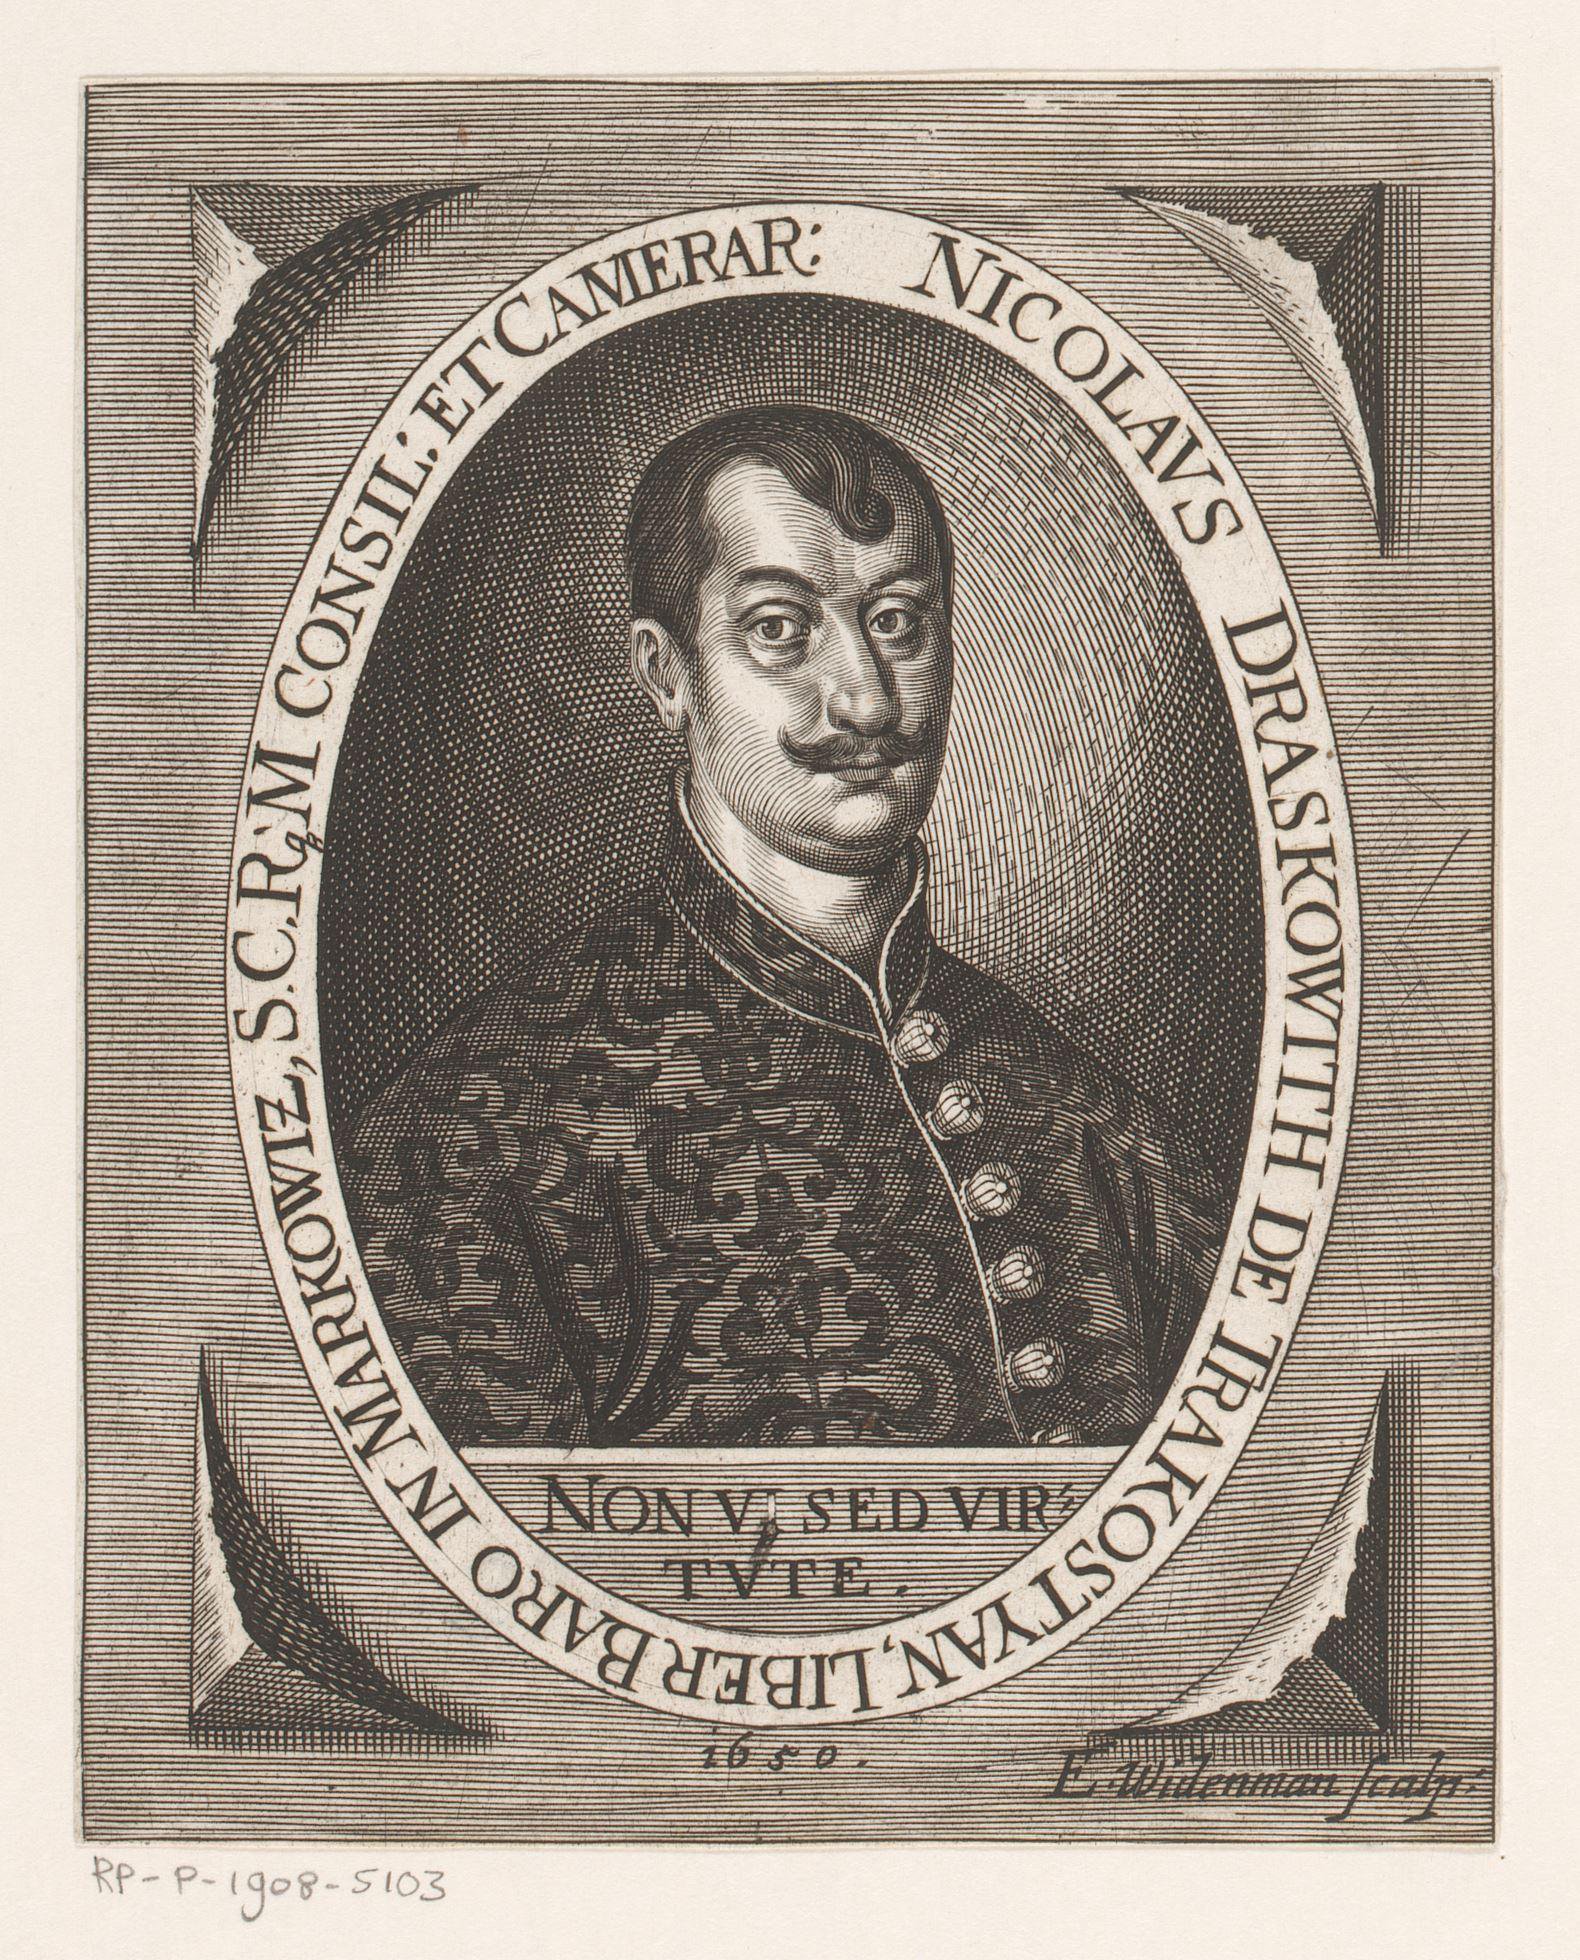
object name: print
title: Portret van Nikola Dras̆ković, graaf van Trakostyáni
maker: elias widemann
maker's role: print maker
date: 1650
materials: paper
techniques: engraving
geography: vienna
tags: earl, historical persons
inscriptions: collector's mark: Lugt 2228